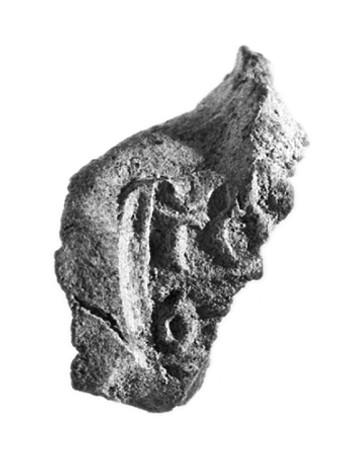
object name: sealing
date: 1981-1640 BCE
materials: mud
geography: egypt